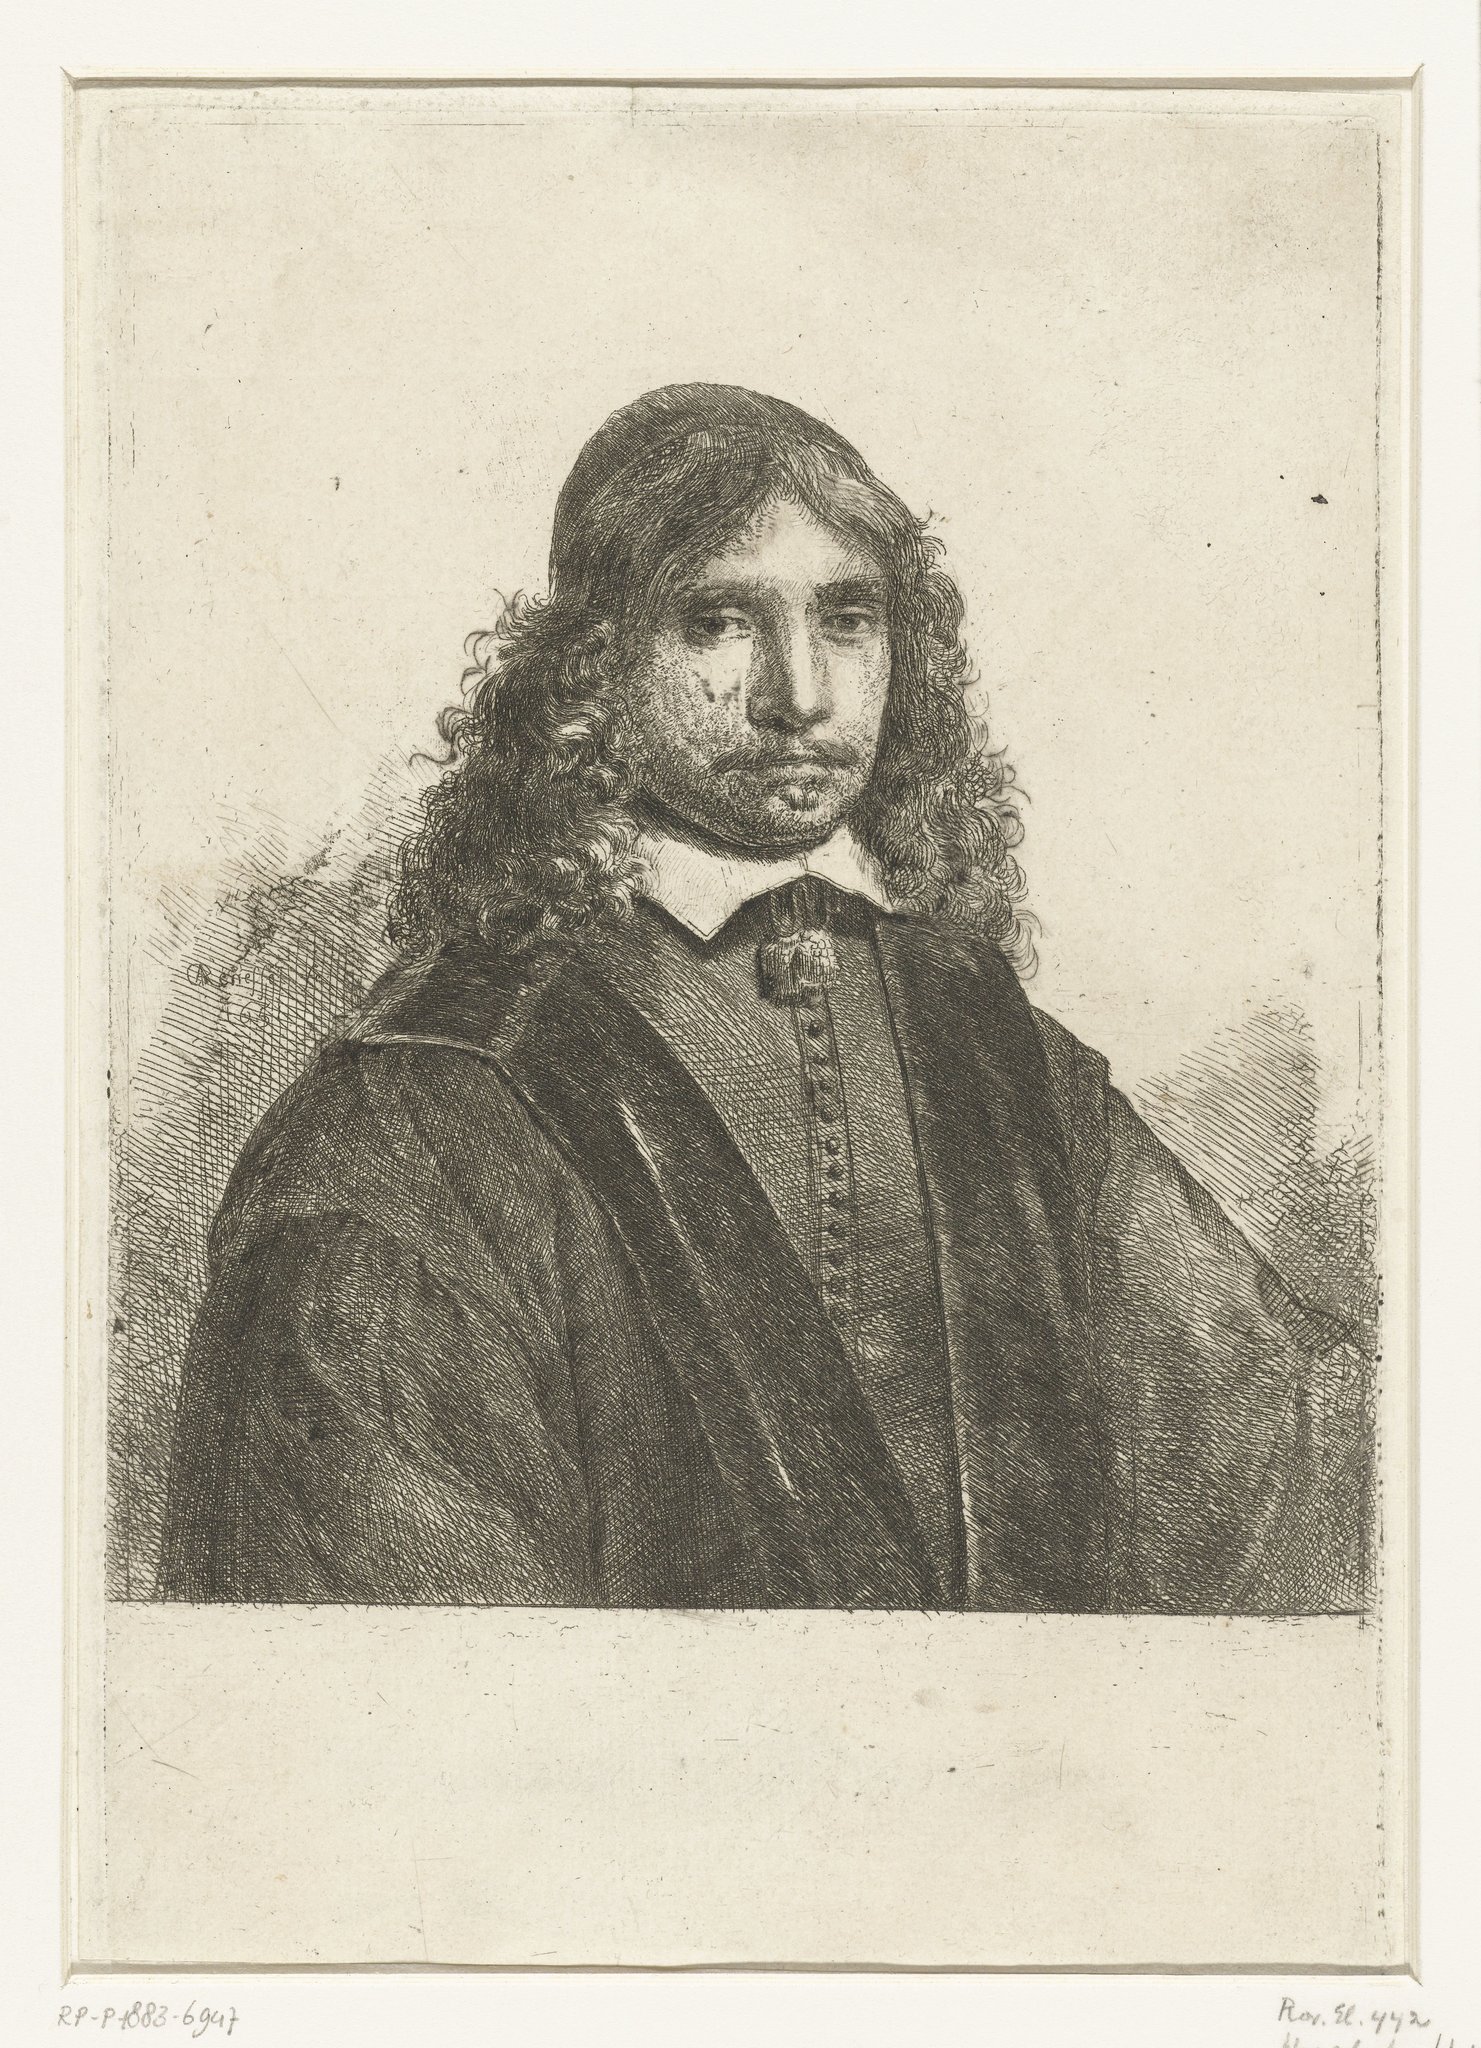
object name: print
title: Portret van een jongeman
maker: constantijn à renesse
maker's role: draughtsman, print maker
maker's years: 1626-1680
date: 1651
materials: paper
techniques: drypoint, etching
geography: netherlands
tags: youth, adolescent (+ three-quarter view)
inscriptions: collector's mark: Lugt 2228a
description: Buste van een jongeman met lang haar en een kleine muts.